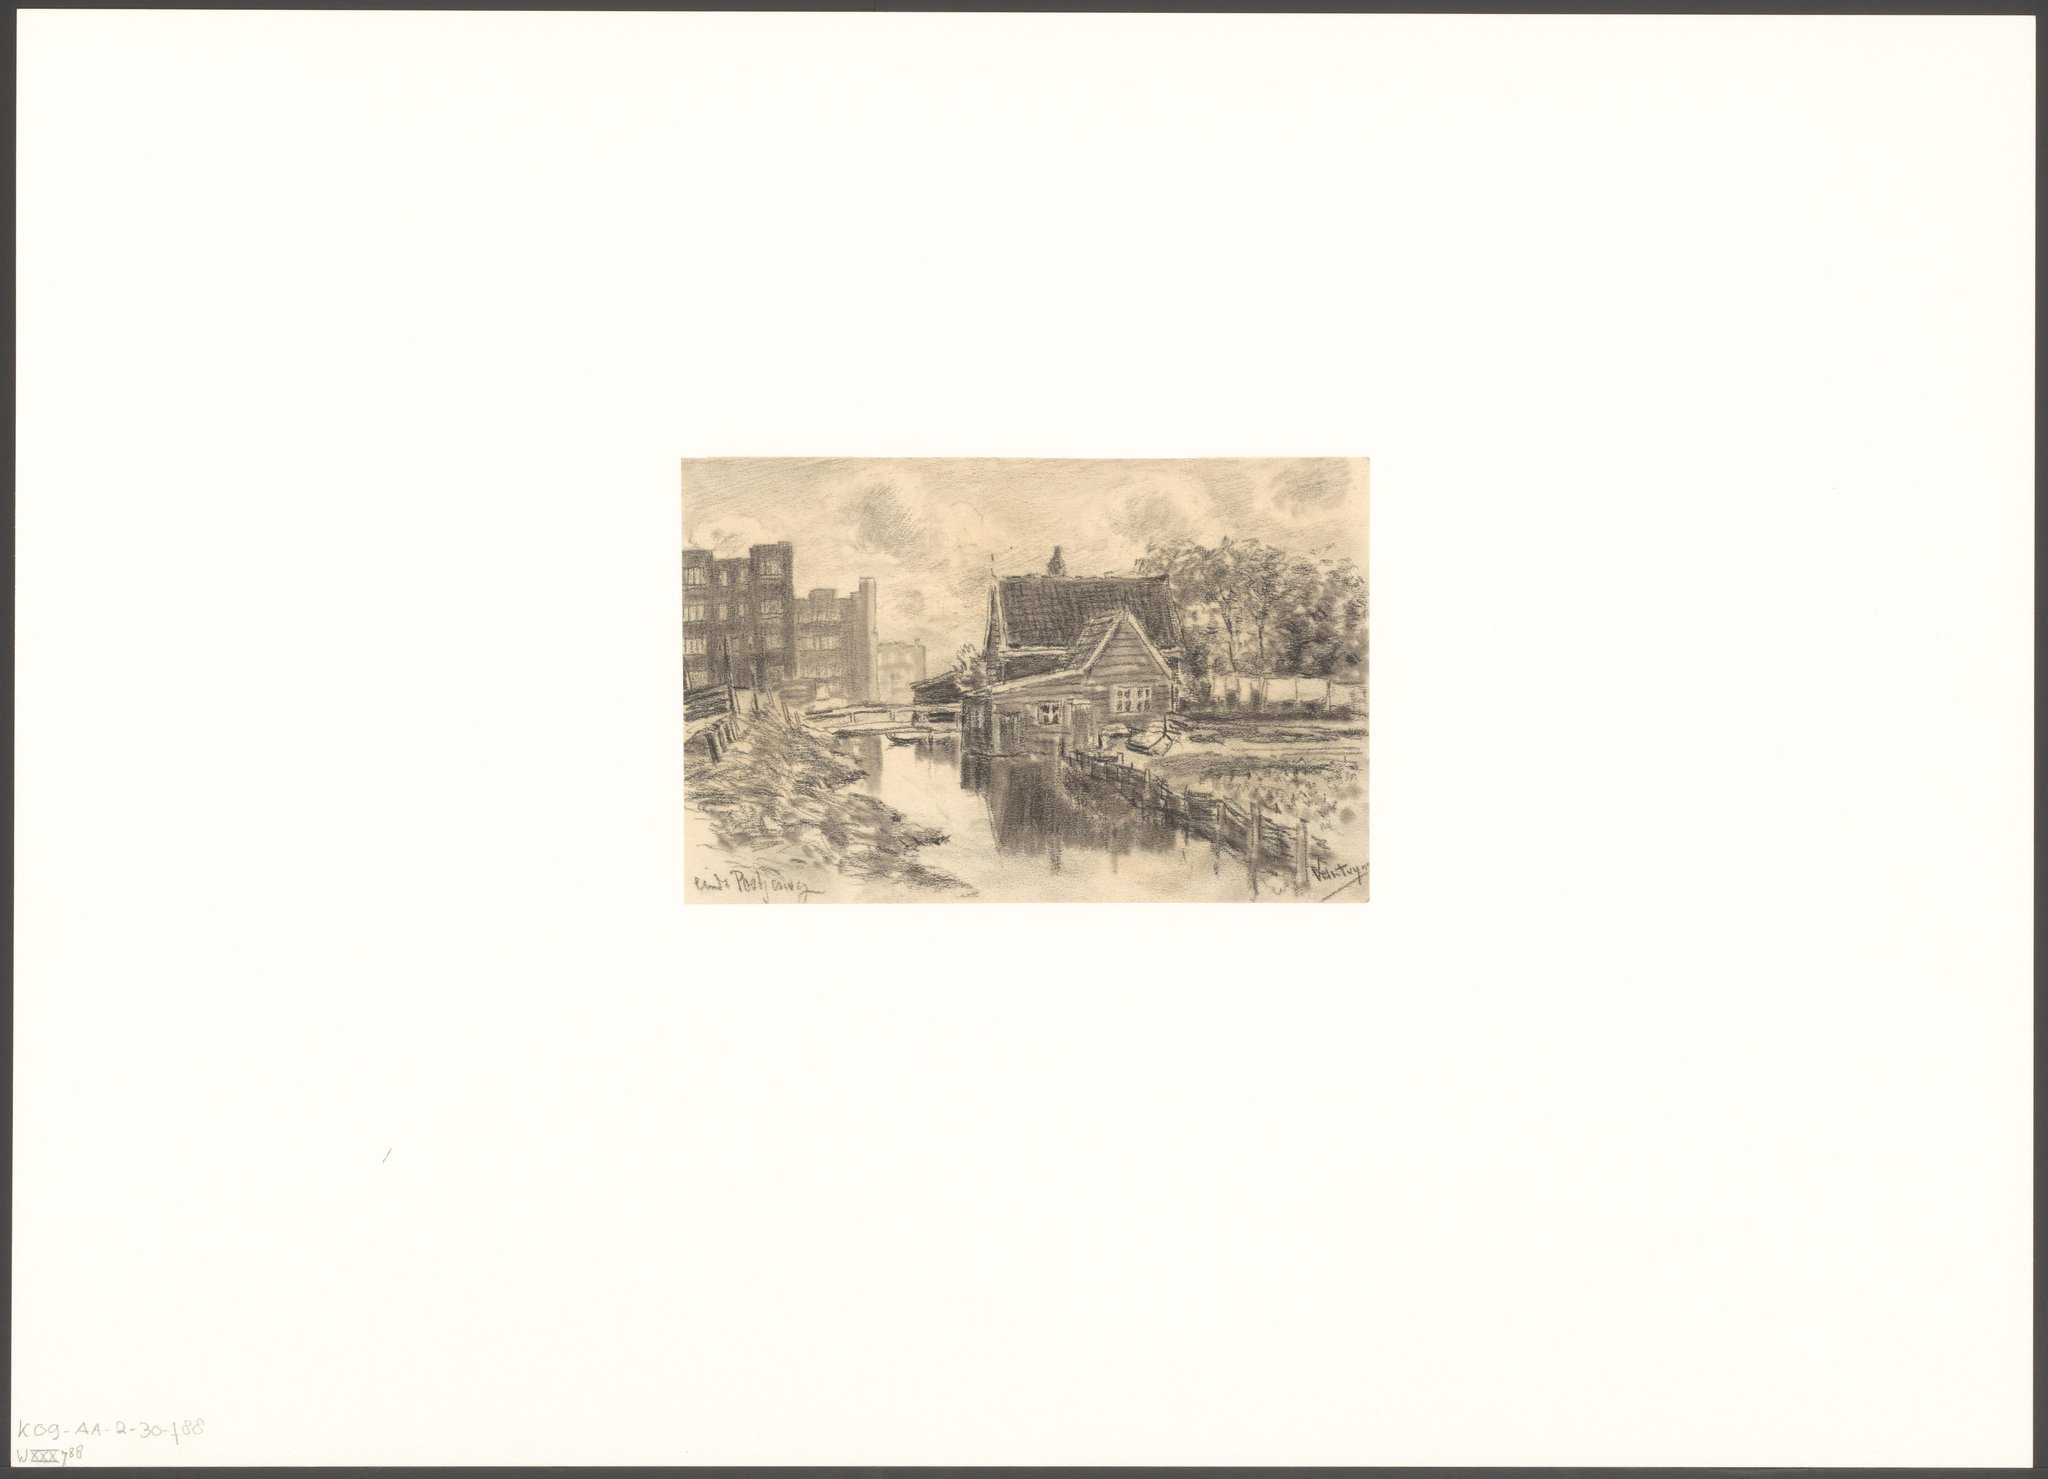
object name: drawing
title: Gezicht op de Postjeswetering achter de Hoofdweg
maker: anthonie van teijn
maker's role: draughtsman, painter, print maker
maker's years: 1863-1943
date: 1910-1927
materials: chalk, paper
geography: amsterdam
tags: city-view in general; 'veduta', canal, bridge in city across river, canal, etc.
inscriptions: inscription: ‘Vaart achter de (...) Teyn Oct 1927’, signature: ‘VanTeyne’, collector's mark: Lugt 800a, inscription: ‘einde Postjesweg’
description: Tekening binnen de Atlas Van Eck ingedeeld op wijknummer 30.